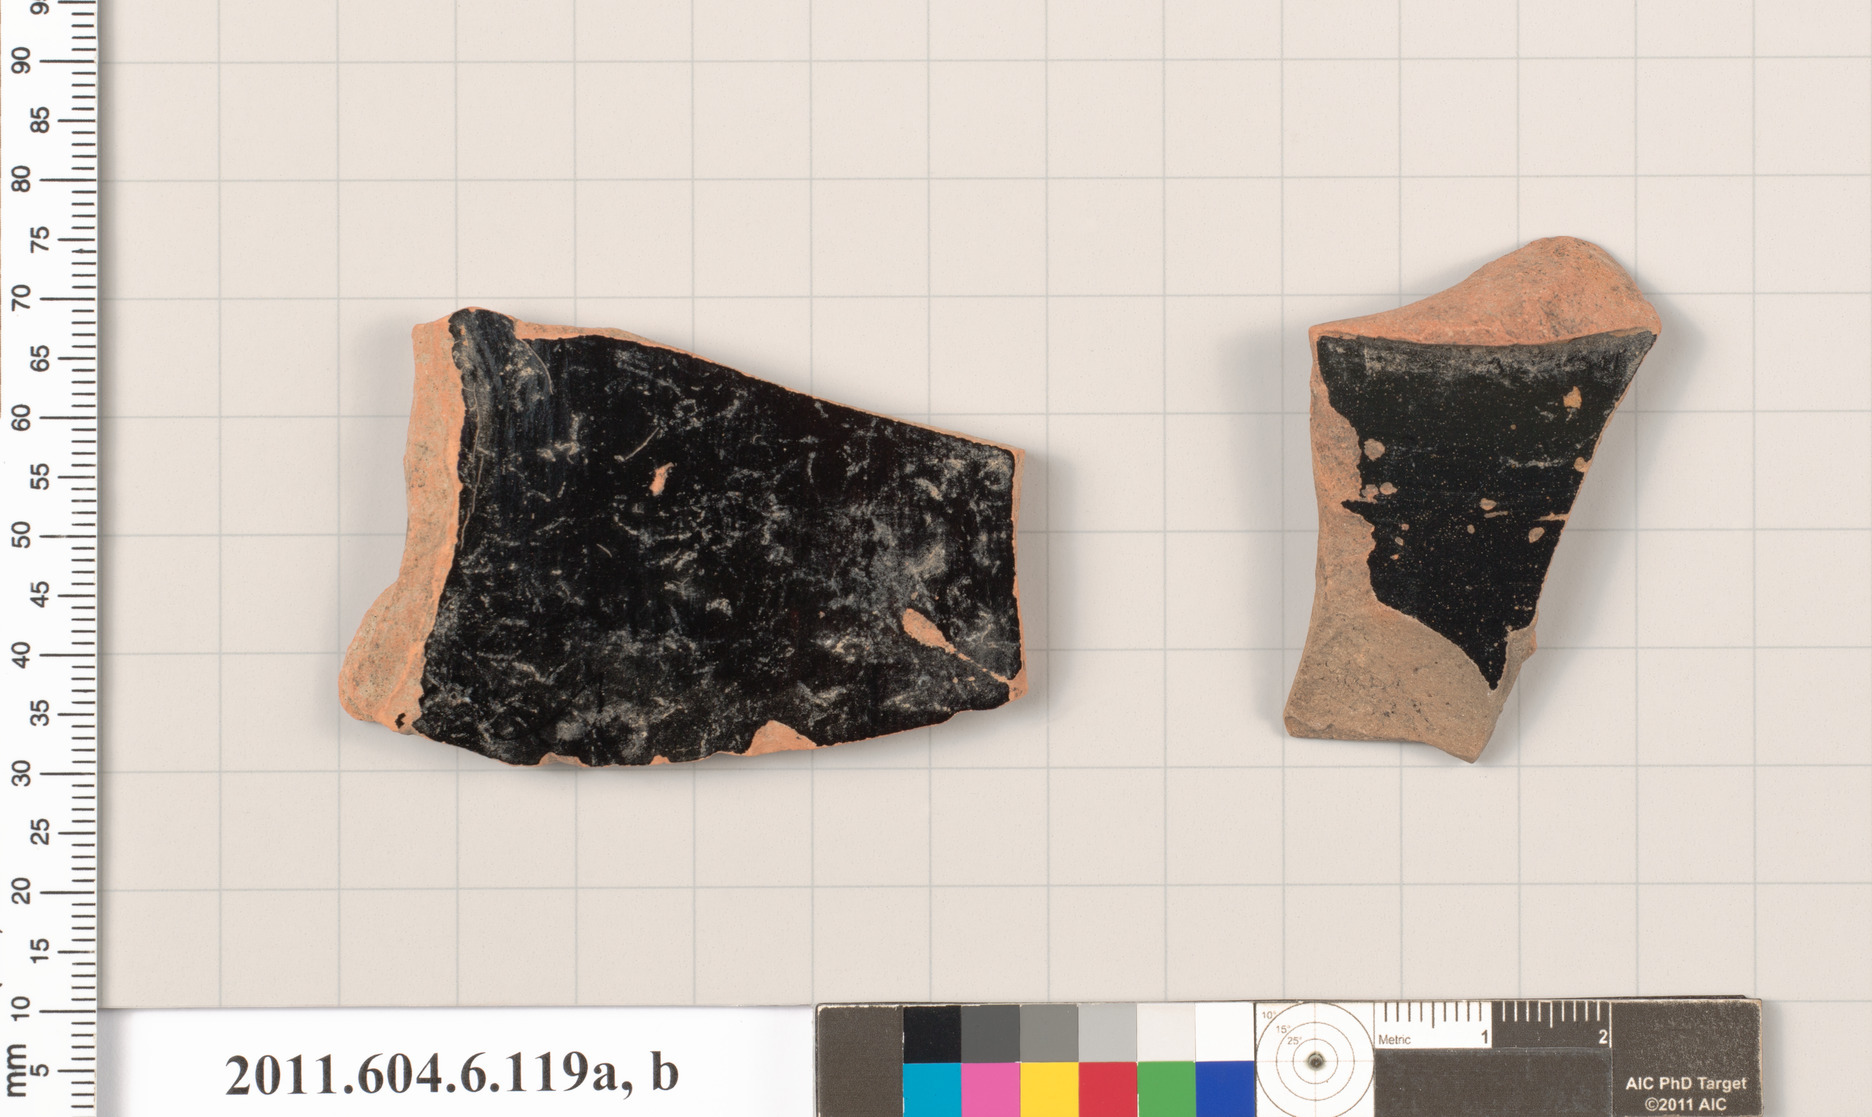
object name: undetermined closed shape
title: Terracotta fragments of closed shapes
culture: greek, attic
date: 600-401 BCE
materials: terracotta